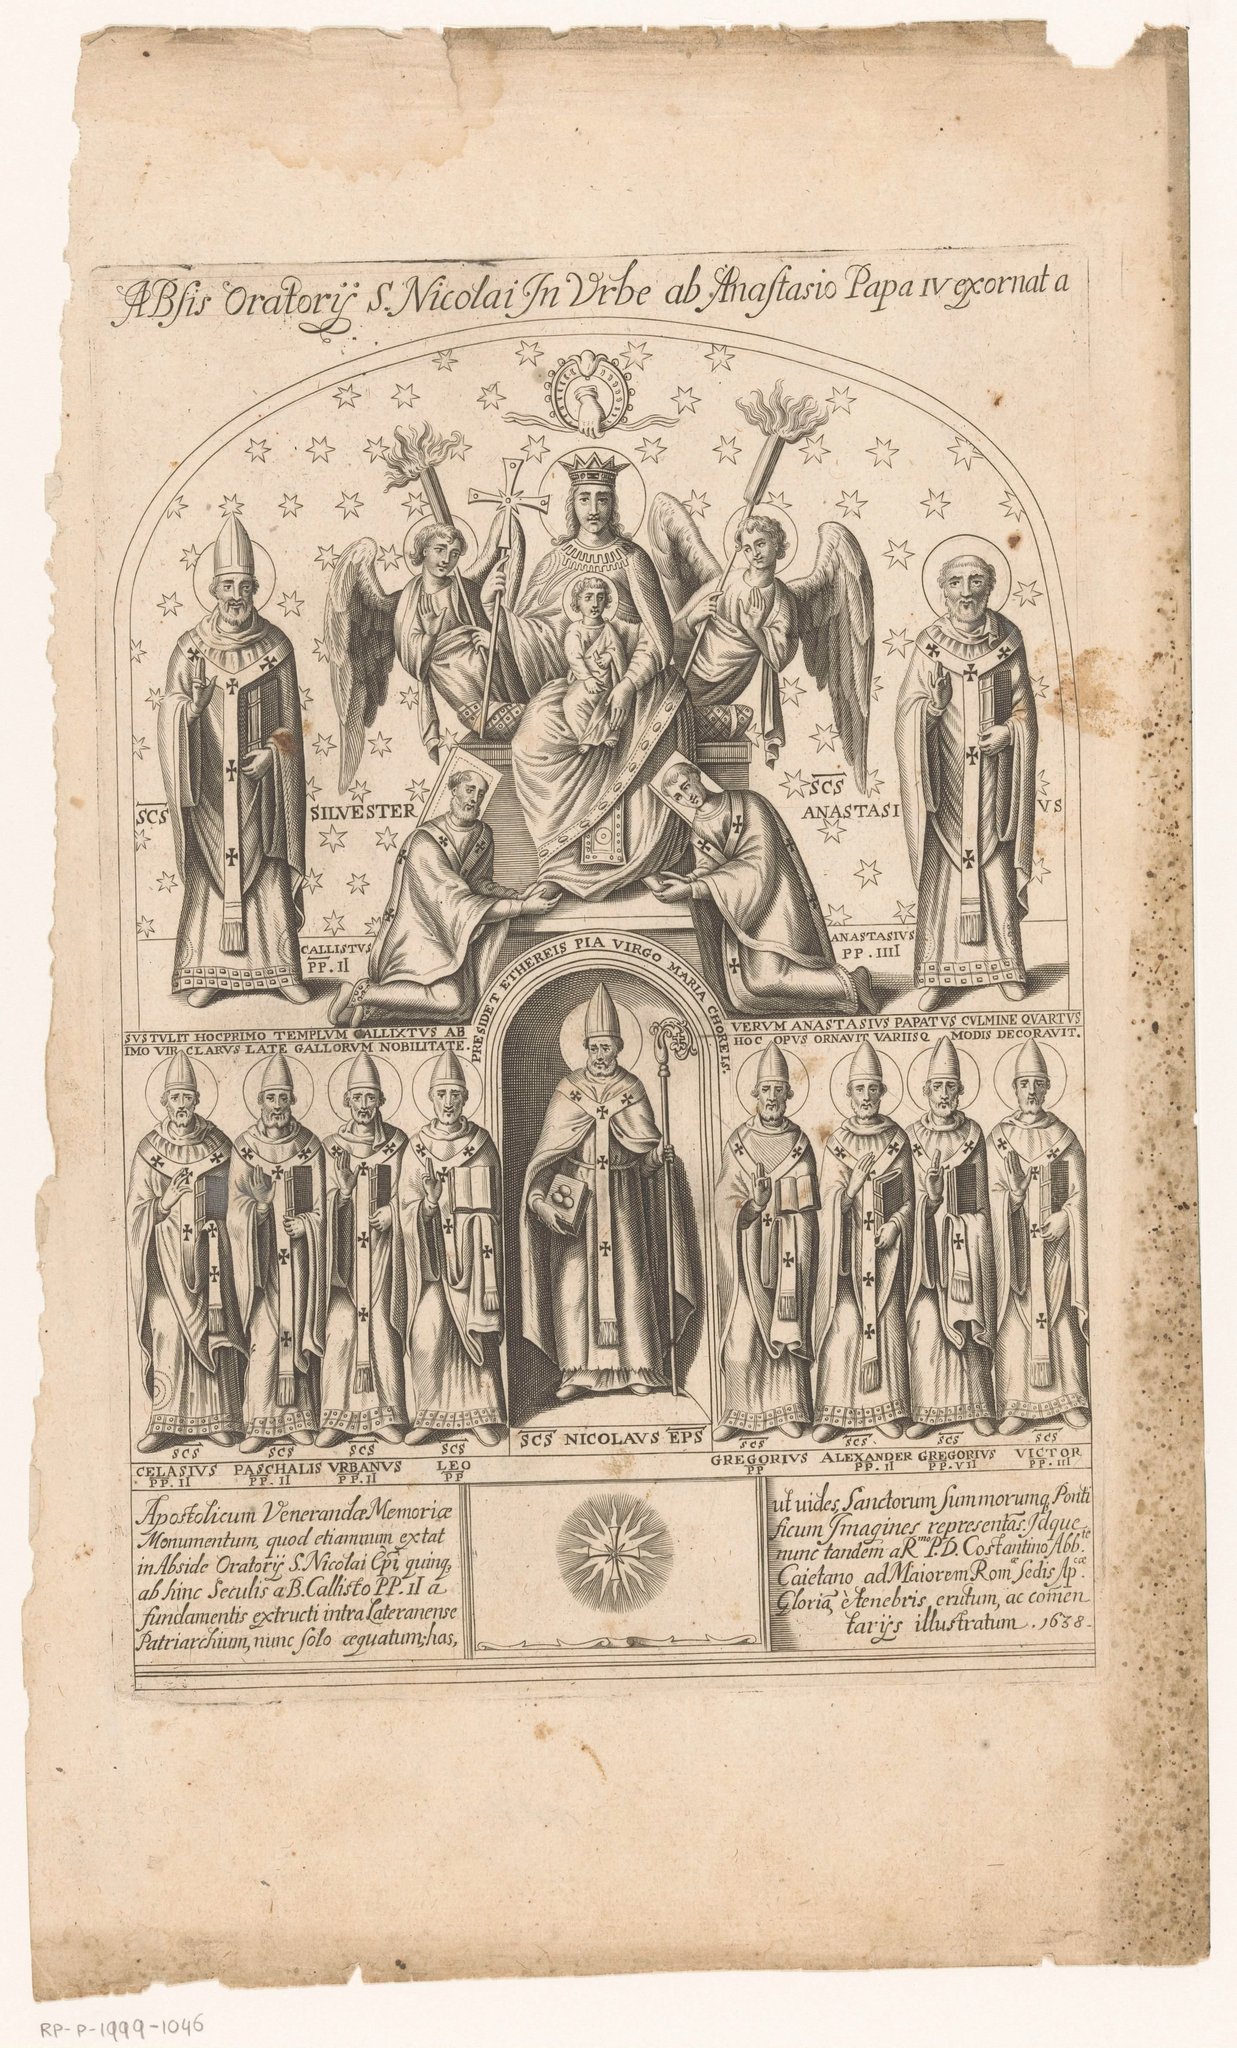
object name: print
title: De heilige Nicolaas omgeven door pausen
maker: Anonymous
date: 1638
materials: paper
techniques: engraving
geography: italy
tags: the bishop nicholas of myra (or bari); possible attributes: anchor, boat, three golden balls (on a book), three purses, three children in a tub, three maidens, specific types of madonna with others, pope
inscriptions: collector's mark: Lugt 2228, collector's mark: Lugt 2760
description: De heilige Nicolaas als bisschop met zijn staf in de linkerhand en een boek met drie gouden ballen erop in de rechterhand. Links en rechts van hem staan vier pausen. Boven Nicolaas de tronende Maria met Kind, geflankeerd door twee engelen en vier pausen. Latijnse tekst in twee kolommen in ondermarge.